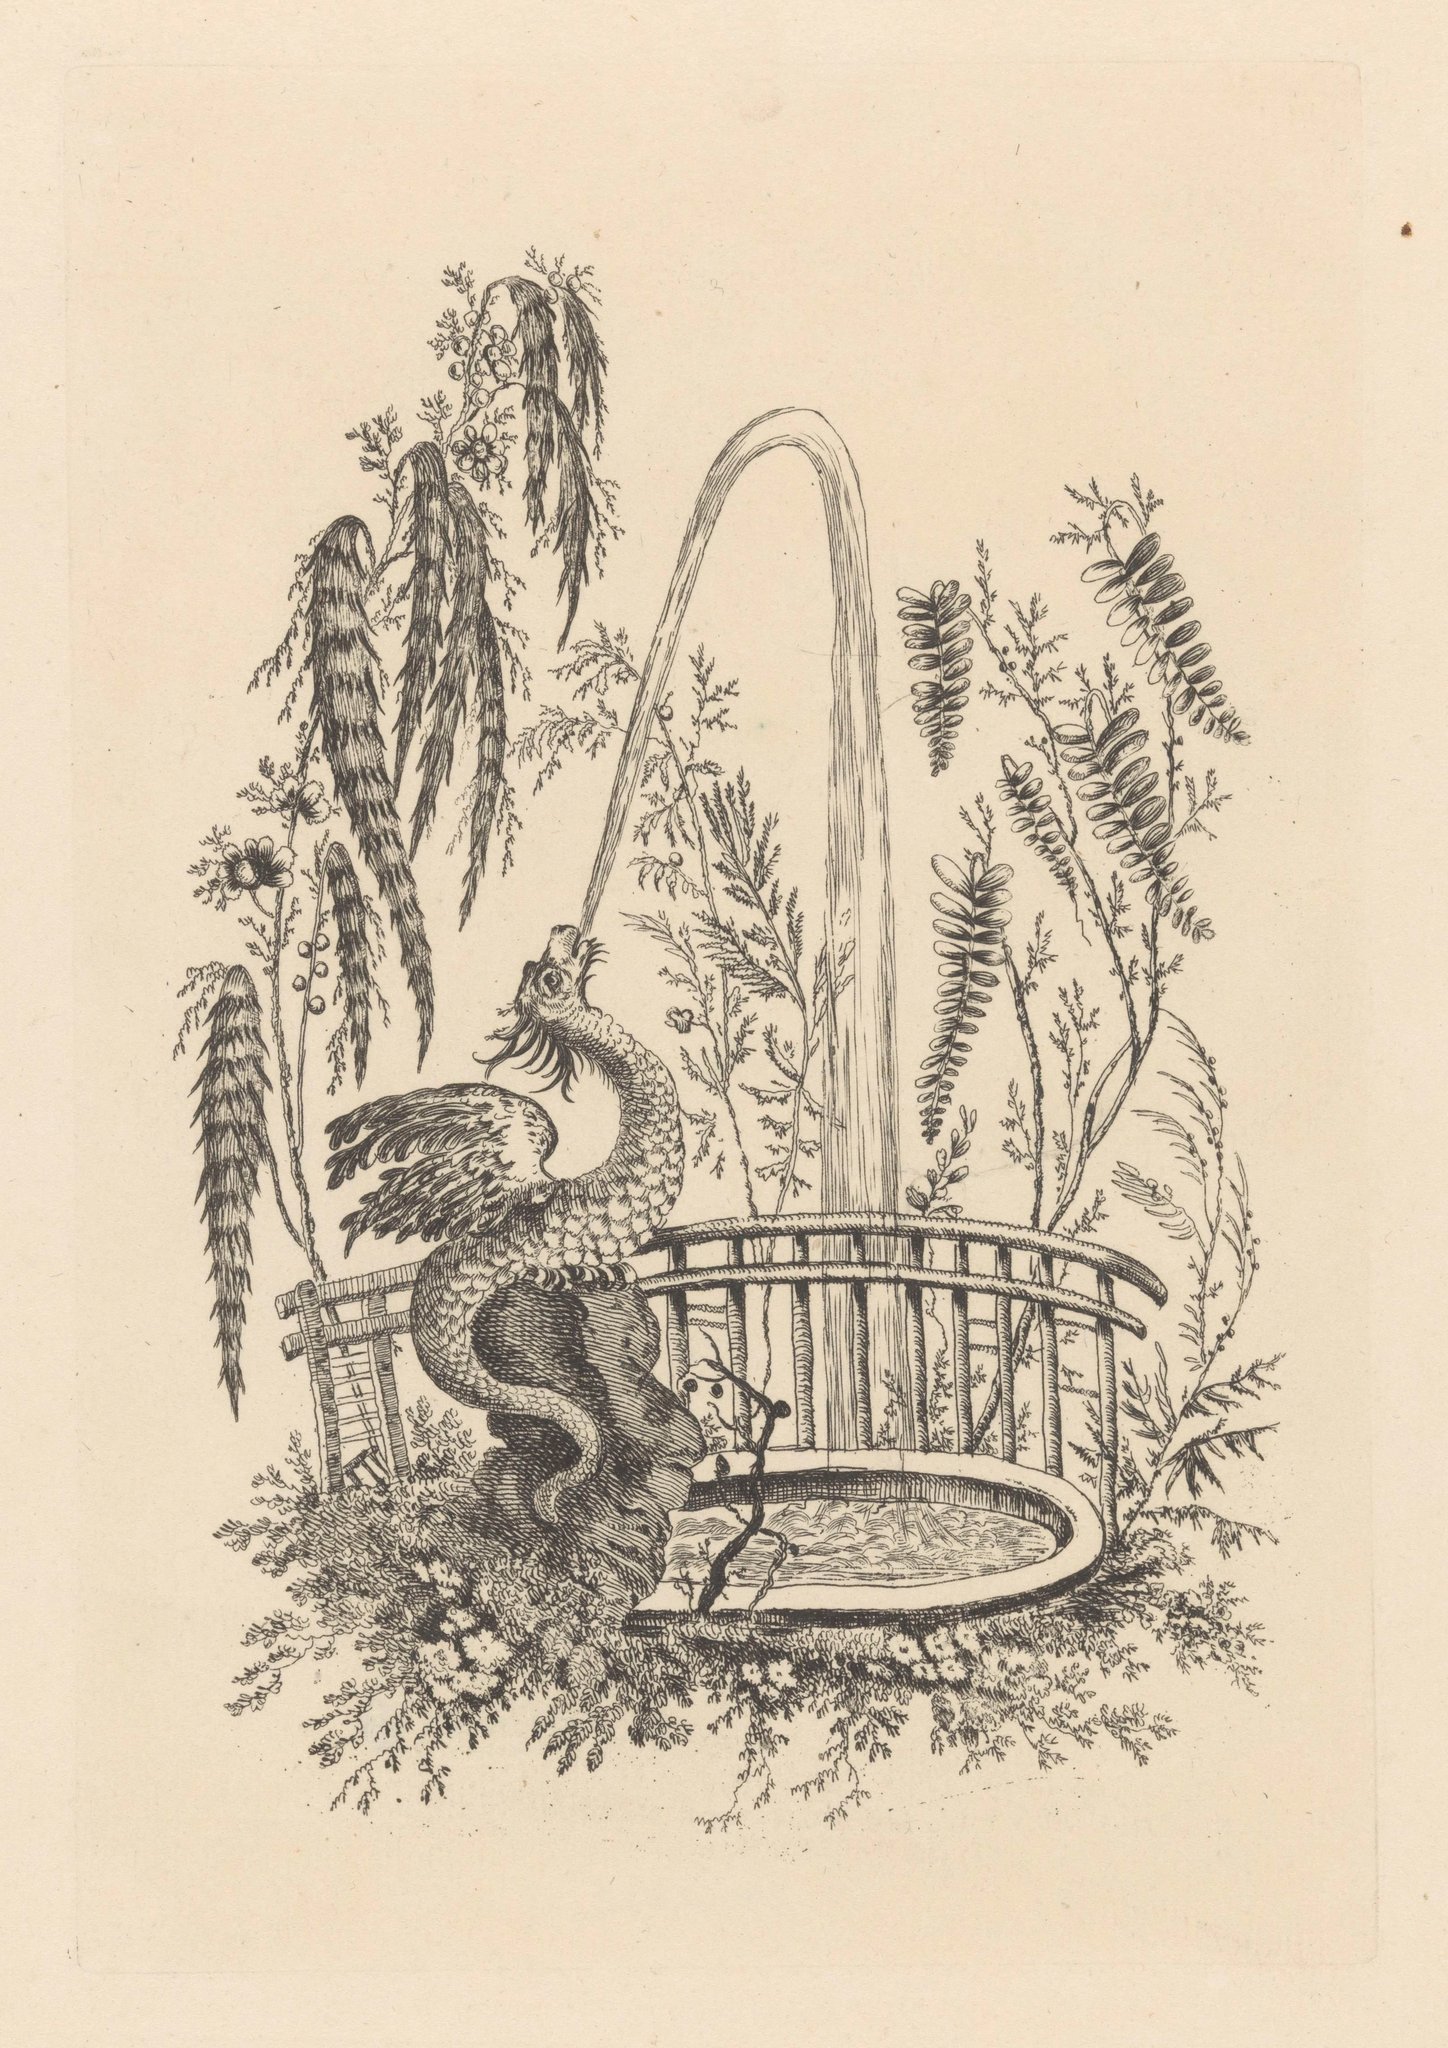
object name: print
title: Recueil Des Fontaines, Chinoises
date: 1770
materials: paper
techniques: etching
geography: paris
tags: dragon, ornamental fountain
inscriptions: collector's mark: Lugt 2760, collector's mark: Lugt 2228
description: In een landschap een fontein in de vorm van een draak, met een hek rondom.